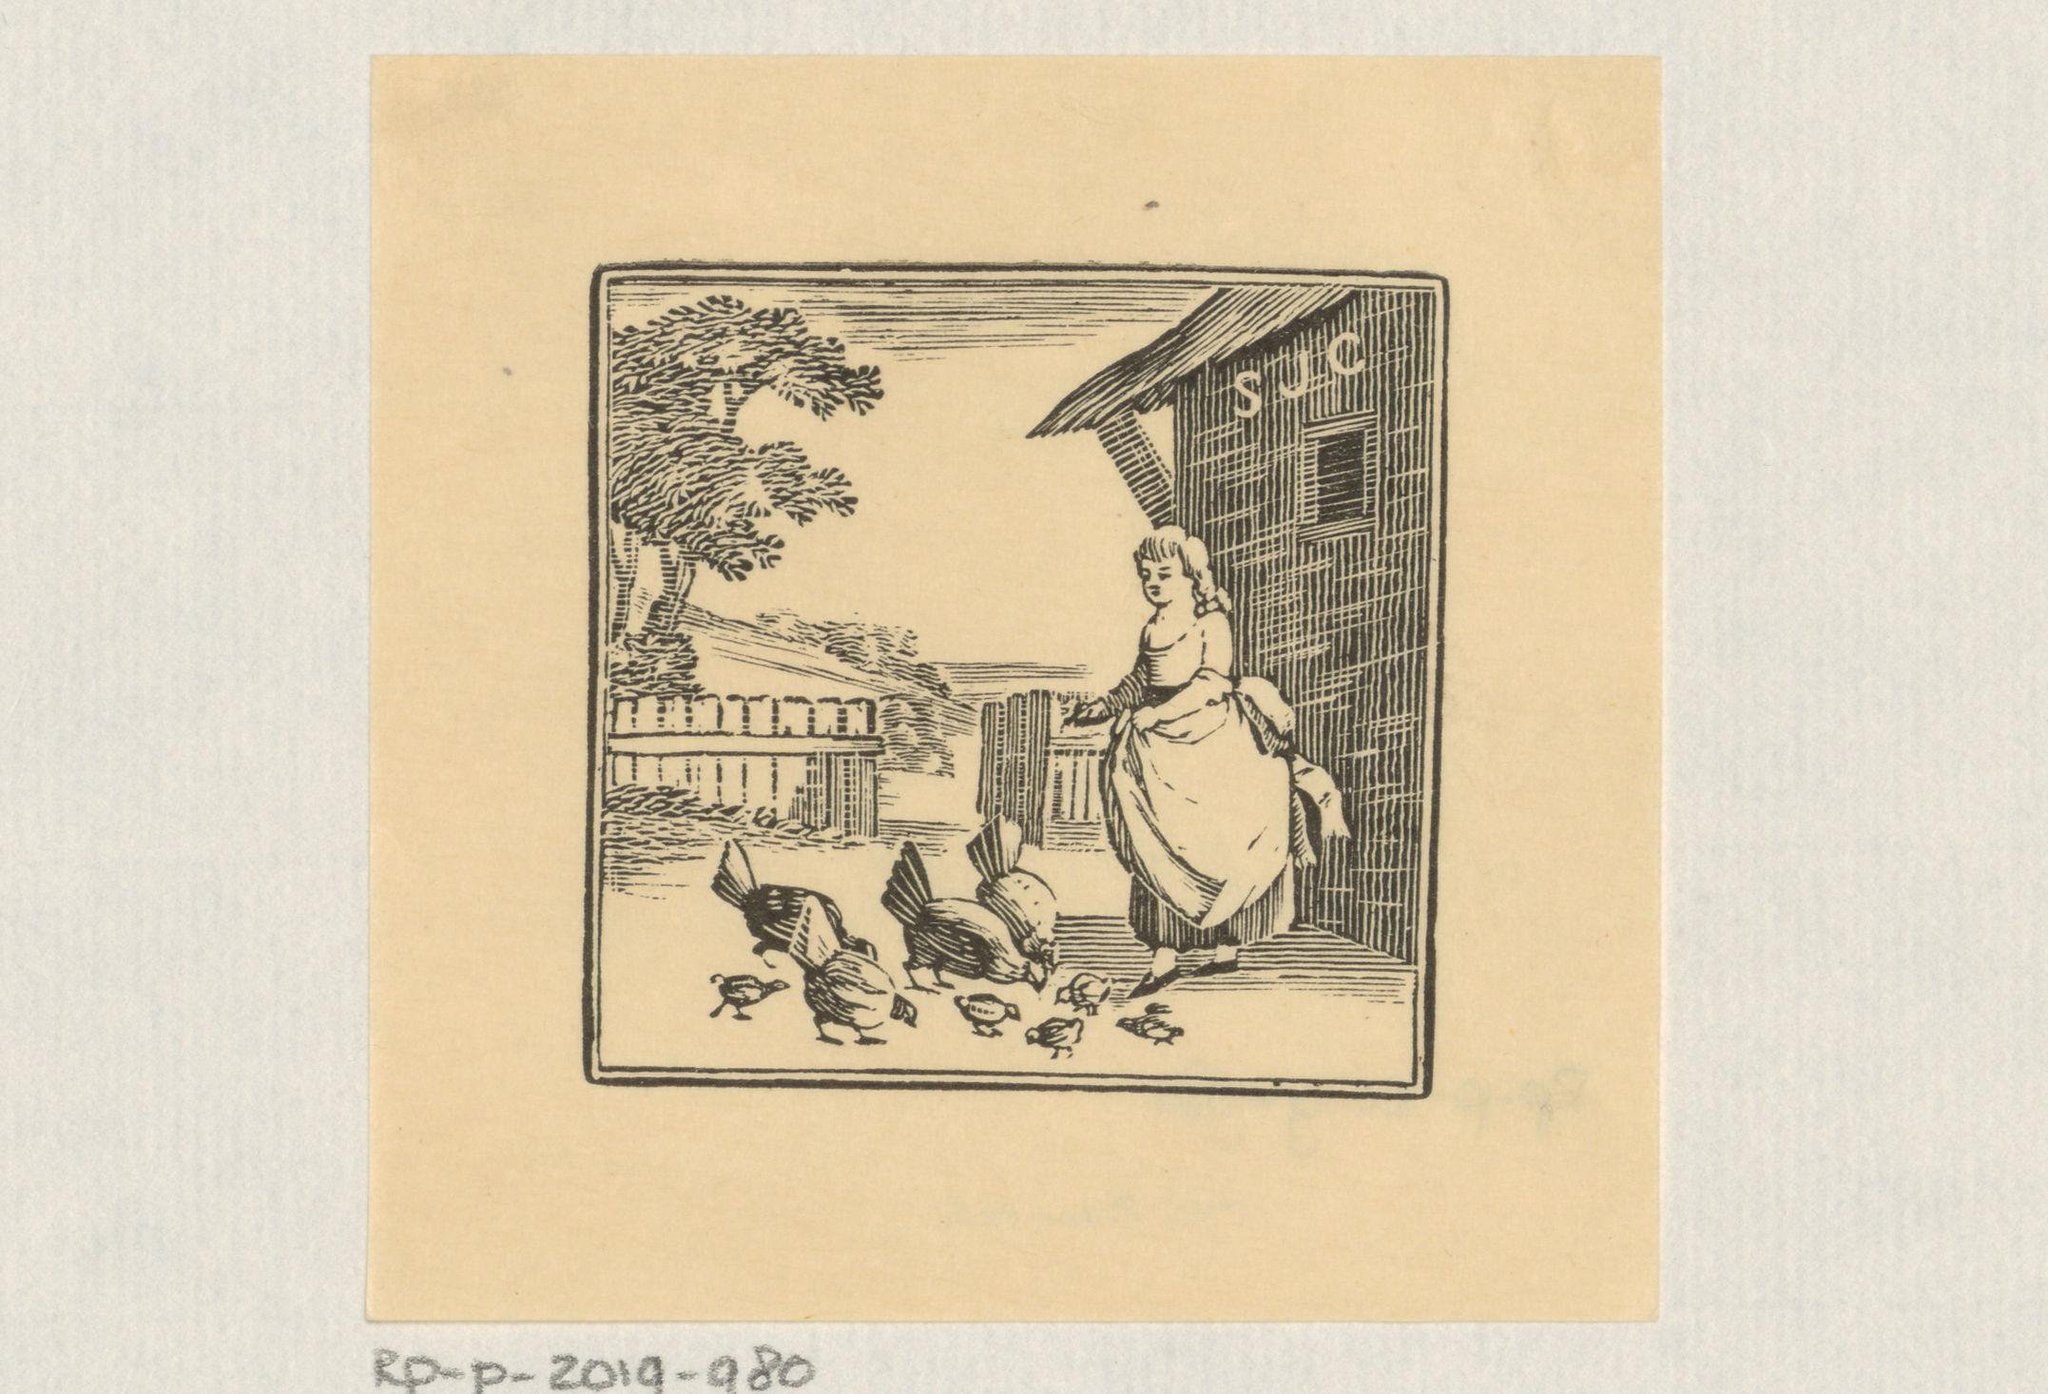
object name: bookplate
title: Ex libris van S.J.C.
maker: thomas bewick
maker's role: draughtsman, painter, print maker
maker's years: 1753-1828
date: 1790-1828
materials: paper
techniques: engraving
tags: fowl (cock, hen, chicken, etc.) (+ feeding animal)